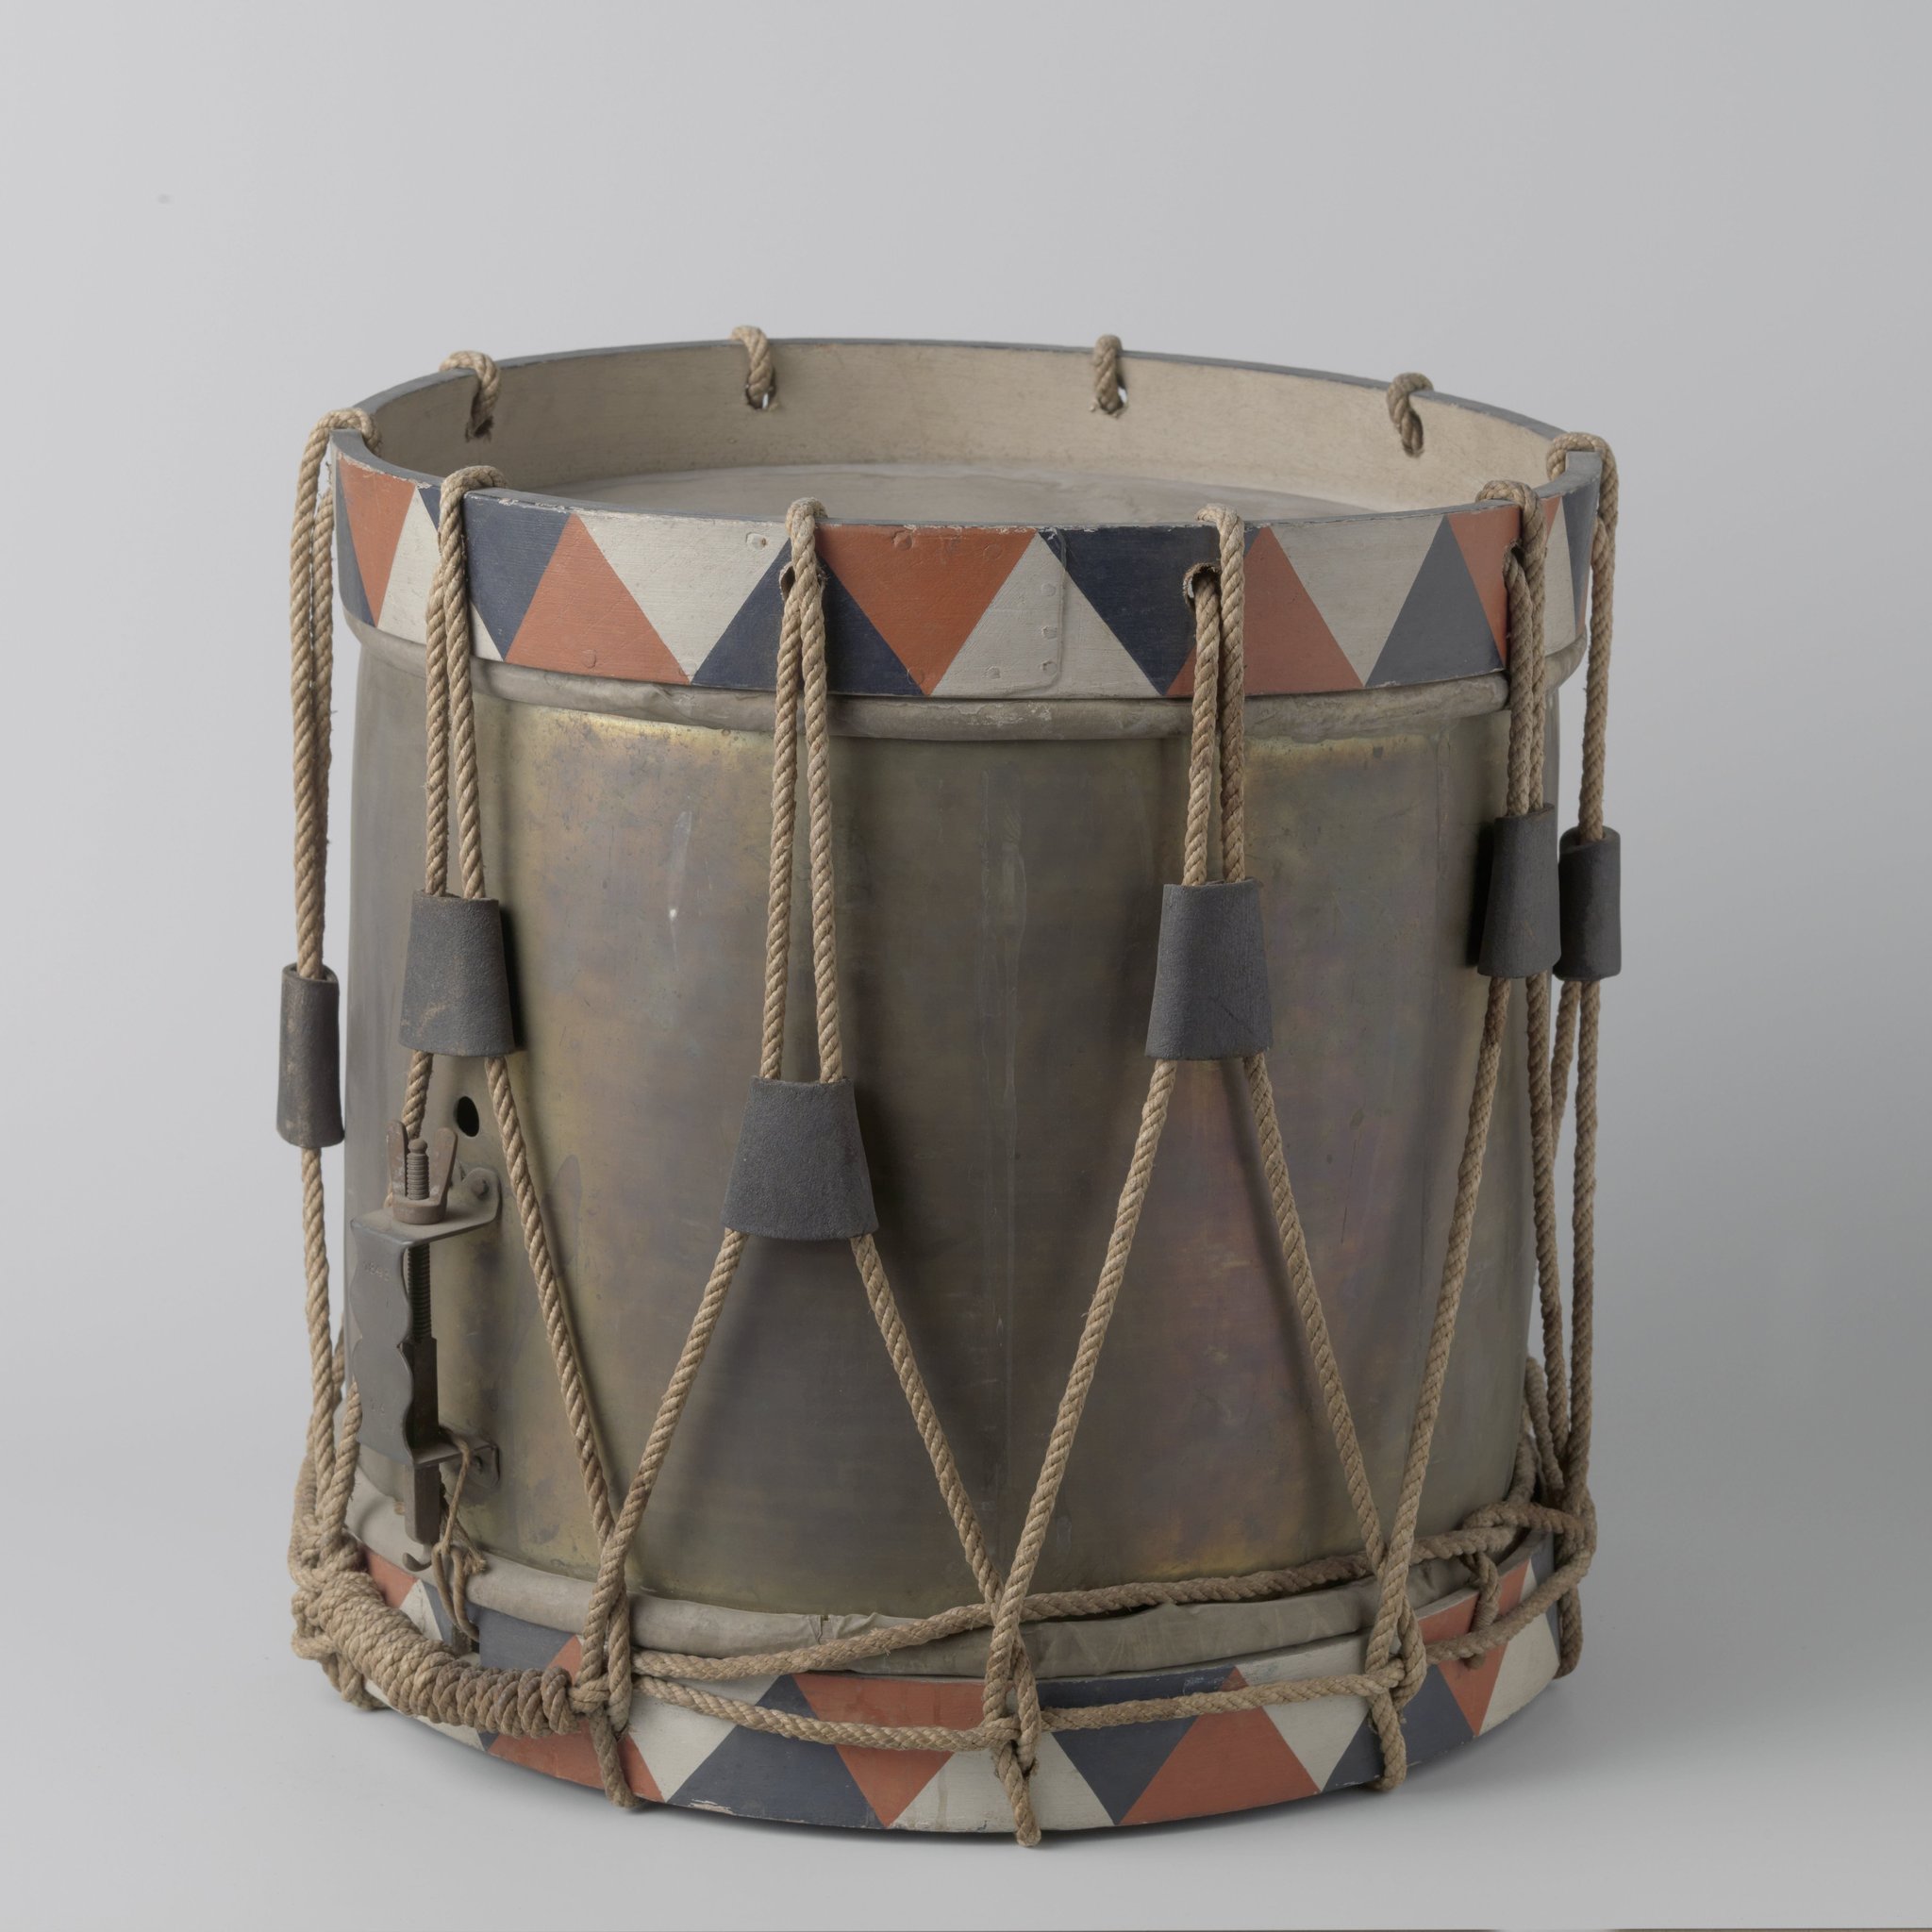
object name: drum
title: Side Drums (39 x)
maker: Anonymous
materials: brass, leather, fiber, wood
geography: netherlands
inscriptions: inscription: ‘1843-16’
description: Music has always been a crucial element of public celebrations, such as military parades, coronations, royal weddings, and funerals, adding grandeur to the solemnity of the occasion. Musical ensembles entrusted with performing music at these events have existed in Europe since the Middle Ages. This display highlights various marching bands and their musical instruments dating from the 16th to the 19th century.